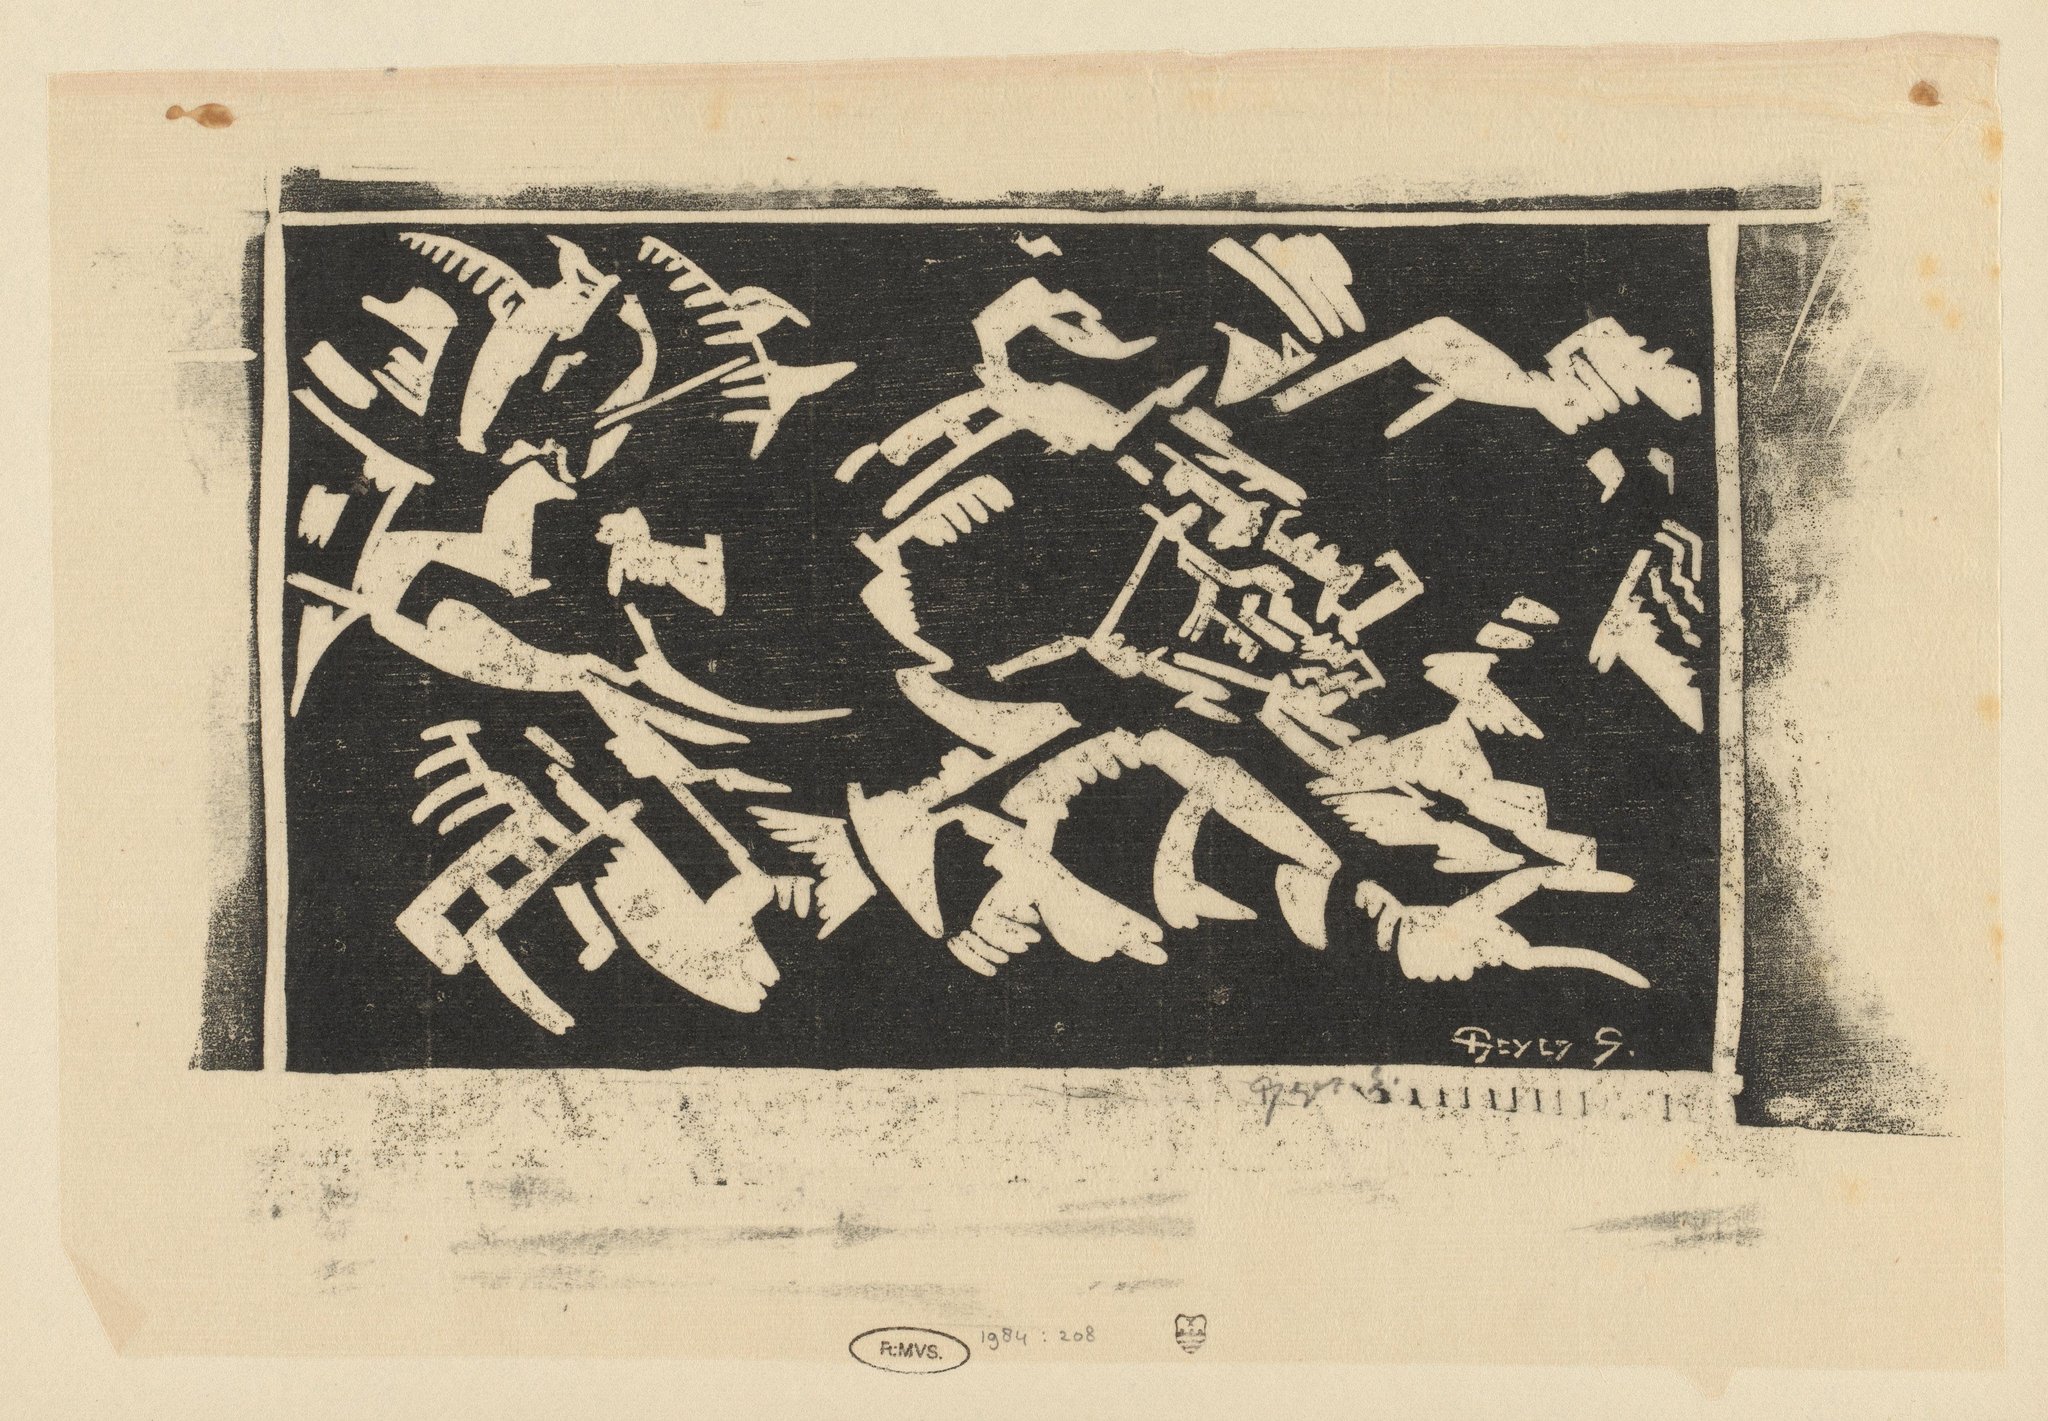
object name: print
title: Compositie van dravende paarden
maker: reijer stolk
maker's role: draughtsman, print maker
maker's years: 1896-1945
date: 1921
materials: paper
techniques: woodcut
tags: riding a horse, ass, or mule; rider, horseman, horses and kindred animals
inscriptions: collector's mark: Lugt 2228, collector's mark: Lugt 2760